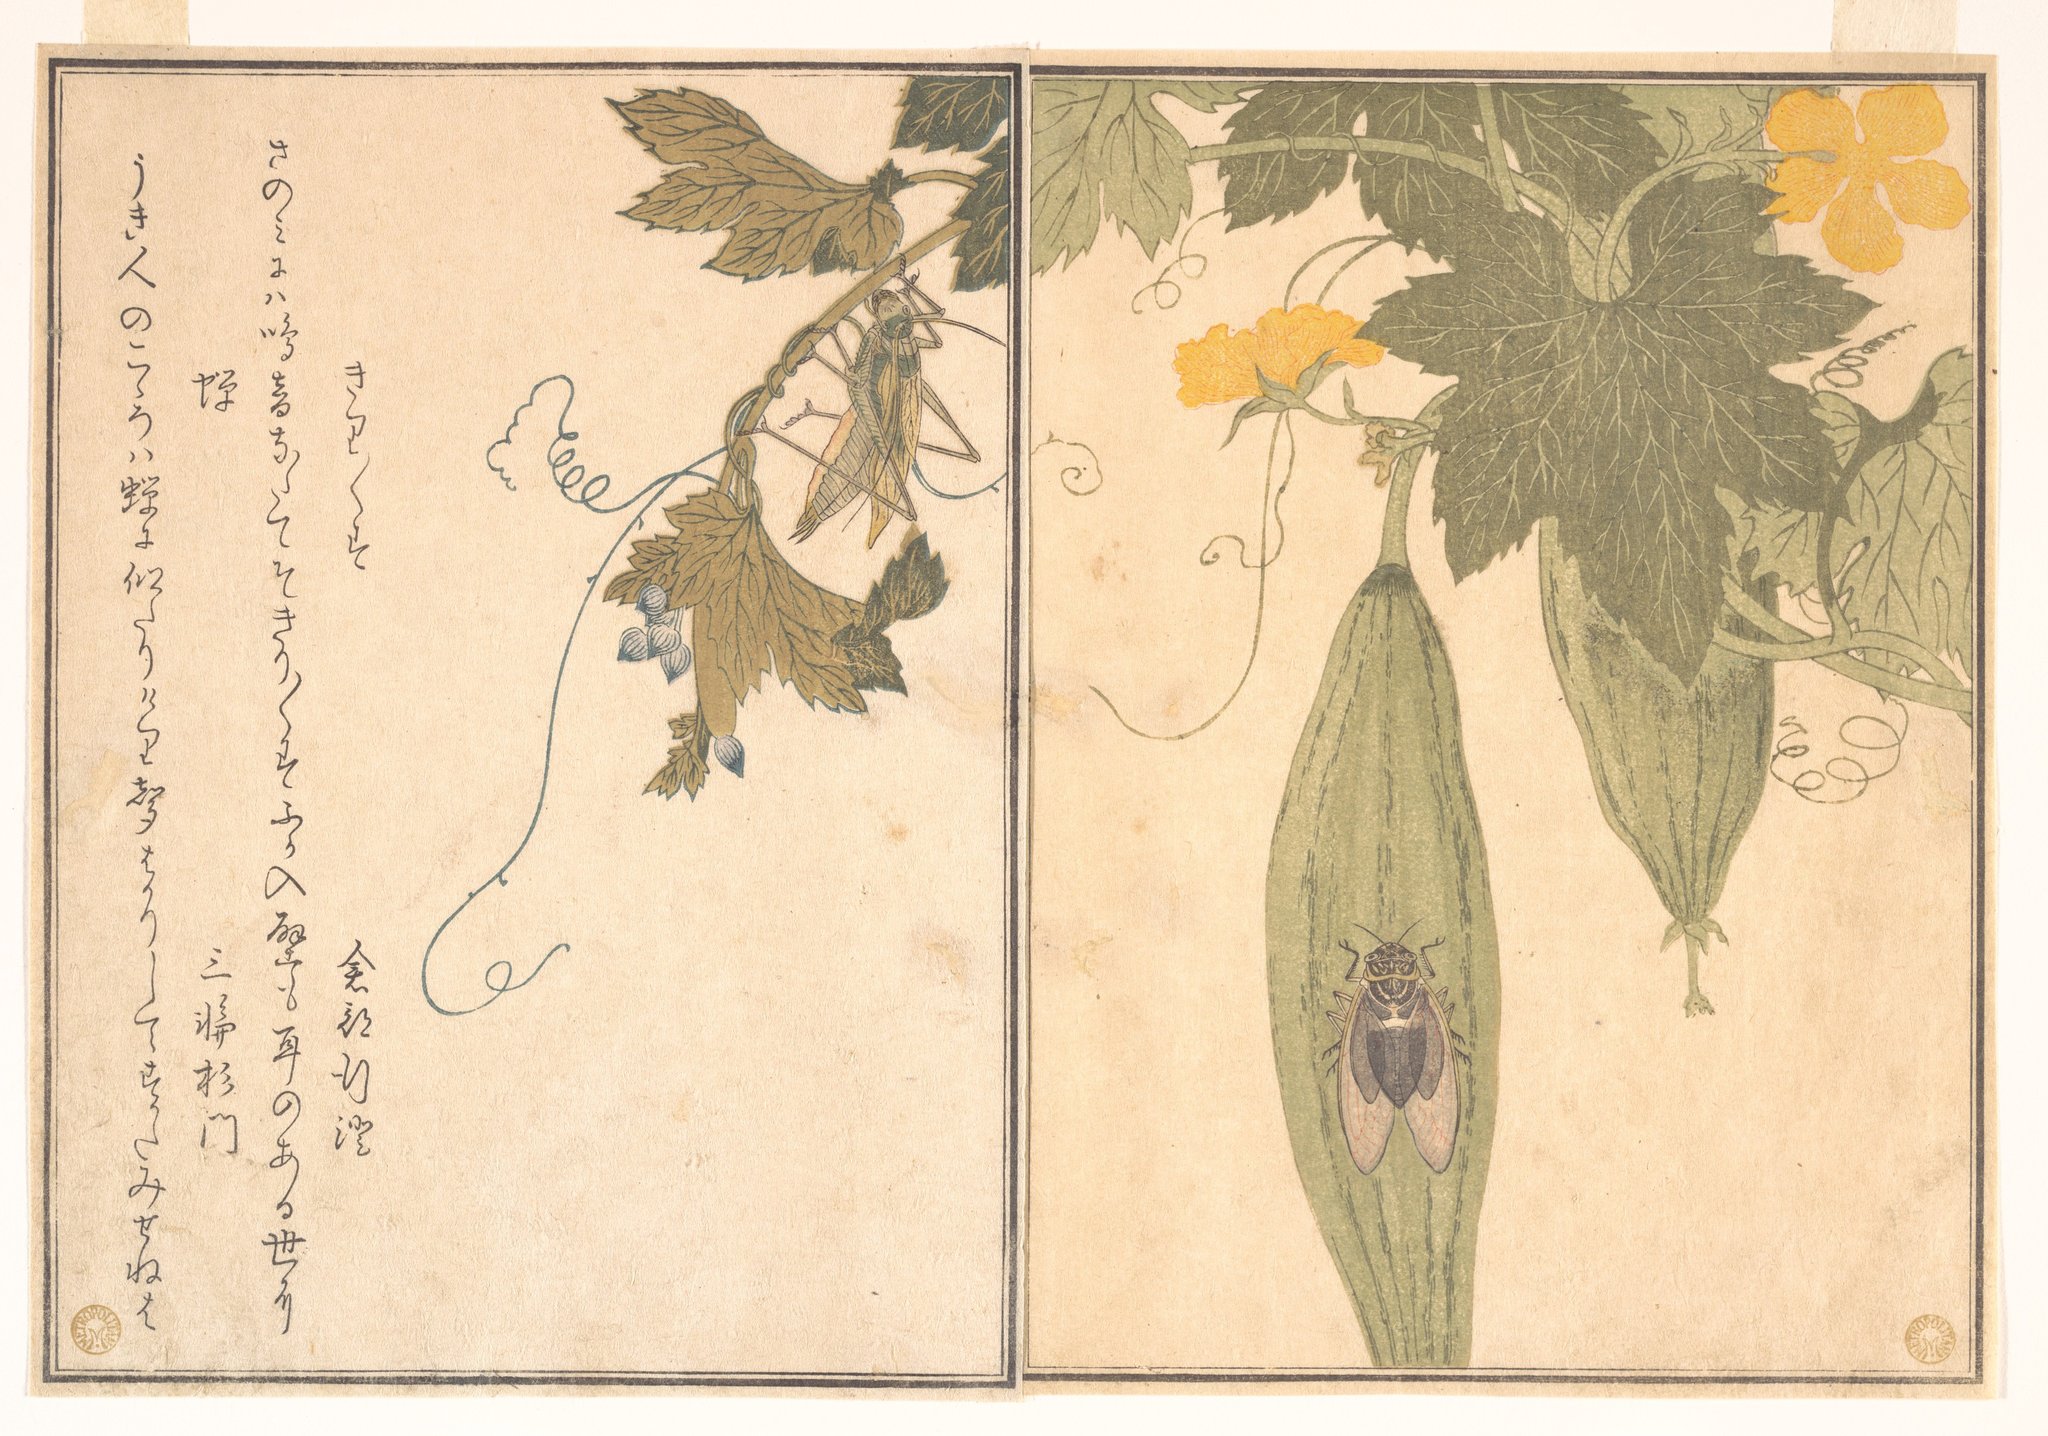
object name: woodblock print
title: Grasshopper (Kirigirisu); Cicada (Semi), from the Picture Book of Crawling Creatures (Ehon mushi erami)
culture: japanese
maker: kitagawa utamaro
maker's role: artist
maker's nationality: japanese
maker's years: 1754-1806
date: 1788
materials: ink, paper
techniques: woodblock print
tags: insects,flowers